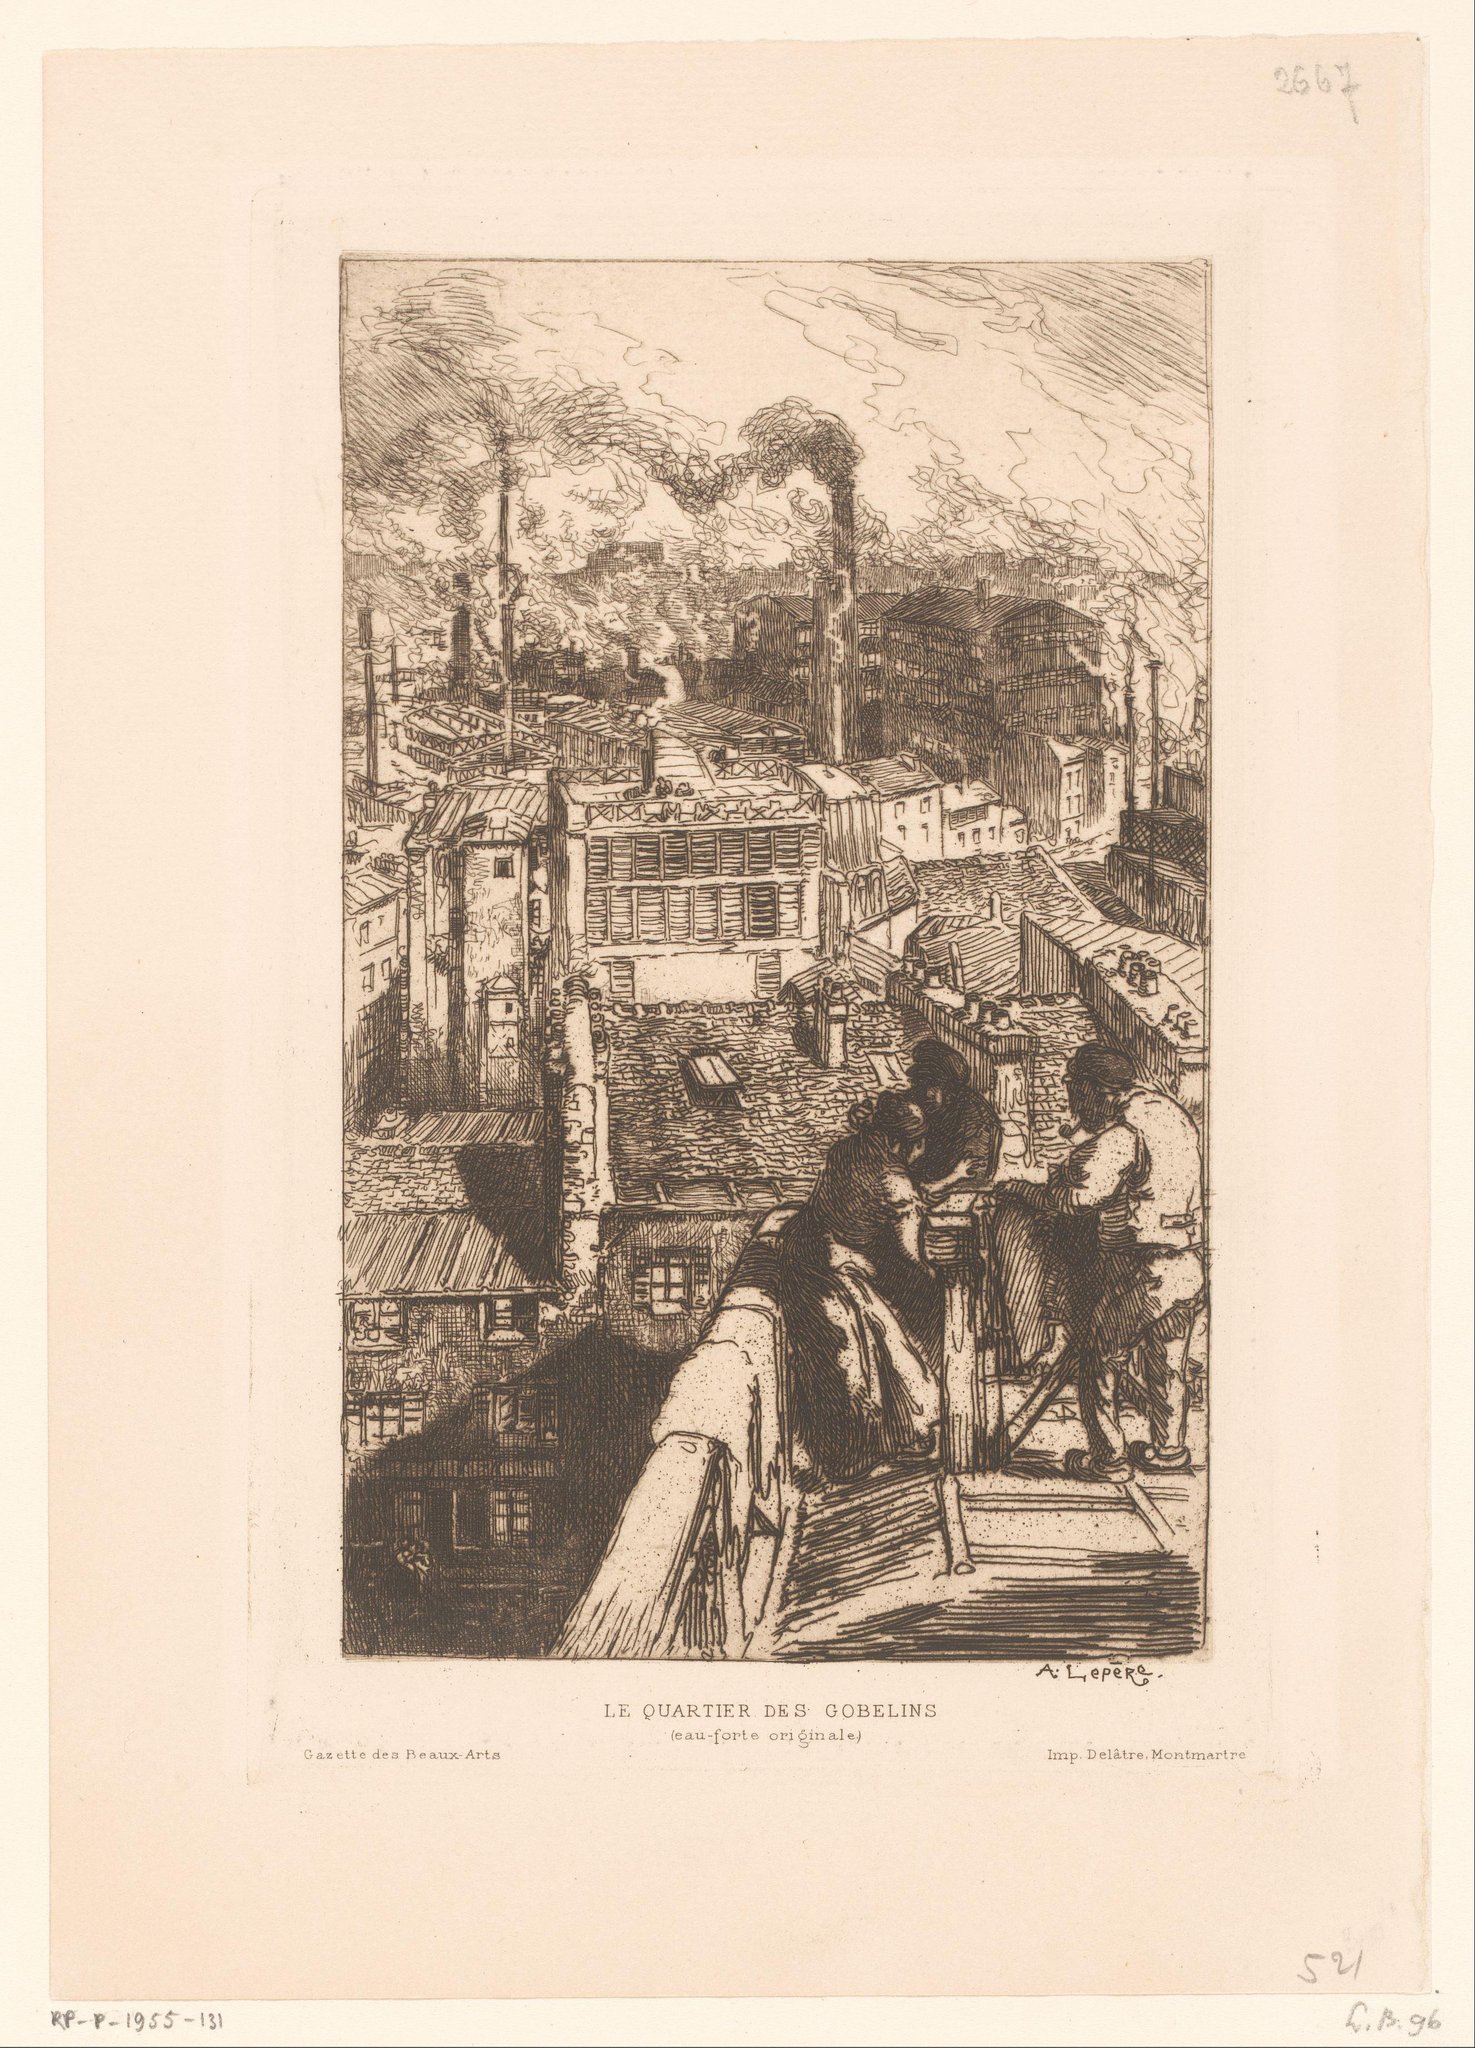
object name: print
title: Gezicht op de daken in het Gobelins district te Parijs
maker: auguste lepère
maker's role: print maker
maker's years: 1849-1918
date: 1859-1918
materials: paper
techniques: drypoint, etching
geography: paris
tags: chimney, roof (of house or building), city-view in general; 'veduta', paris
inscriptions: collector's mark: Lugt 2228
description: Gepubliceerd in Gazette des Beaux-Arts, 1896, dl. 16, p. 300. Zie IFF après 1800, p. 26.